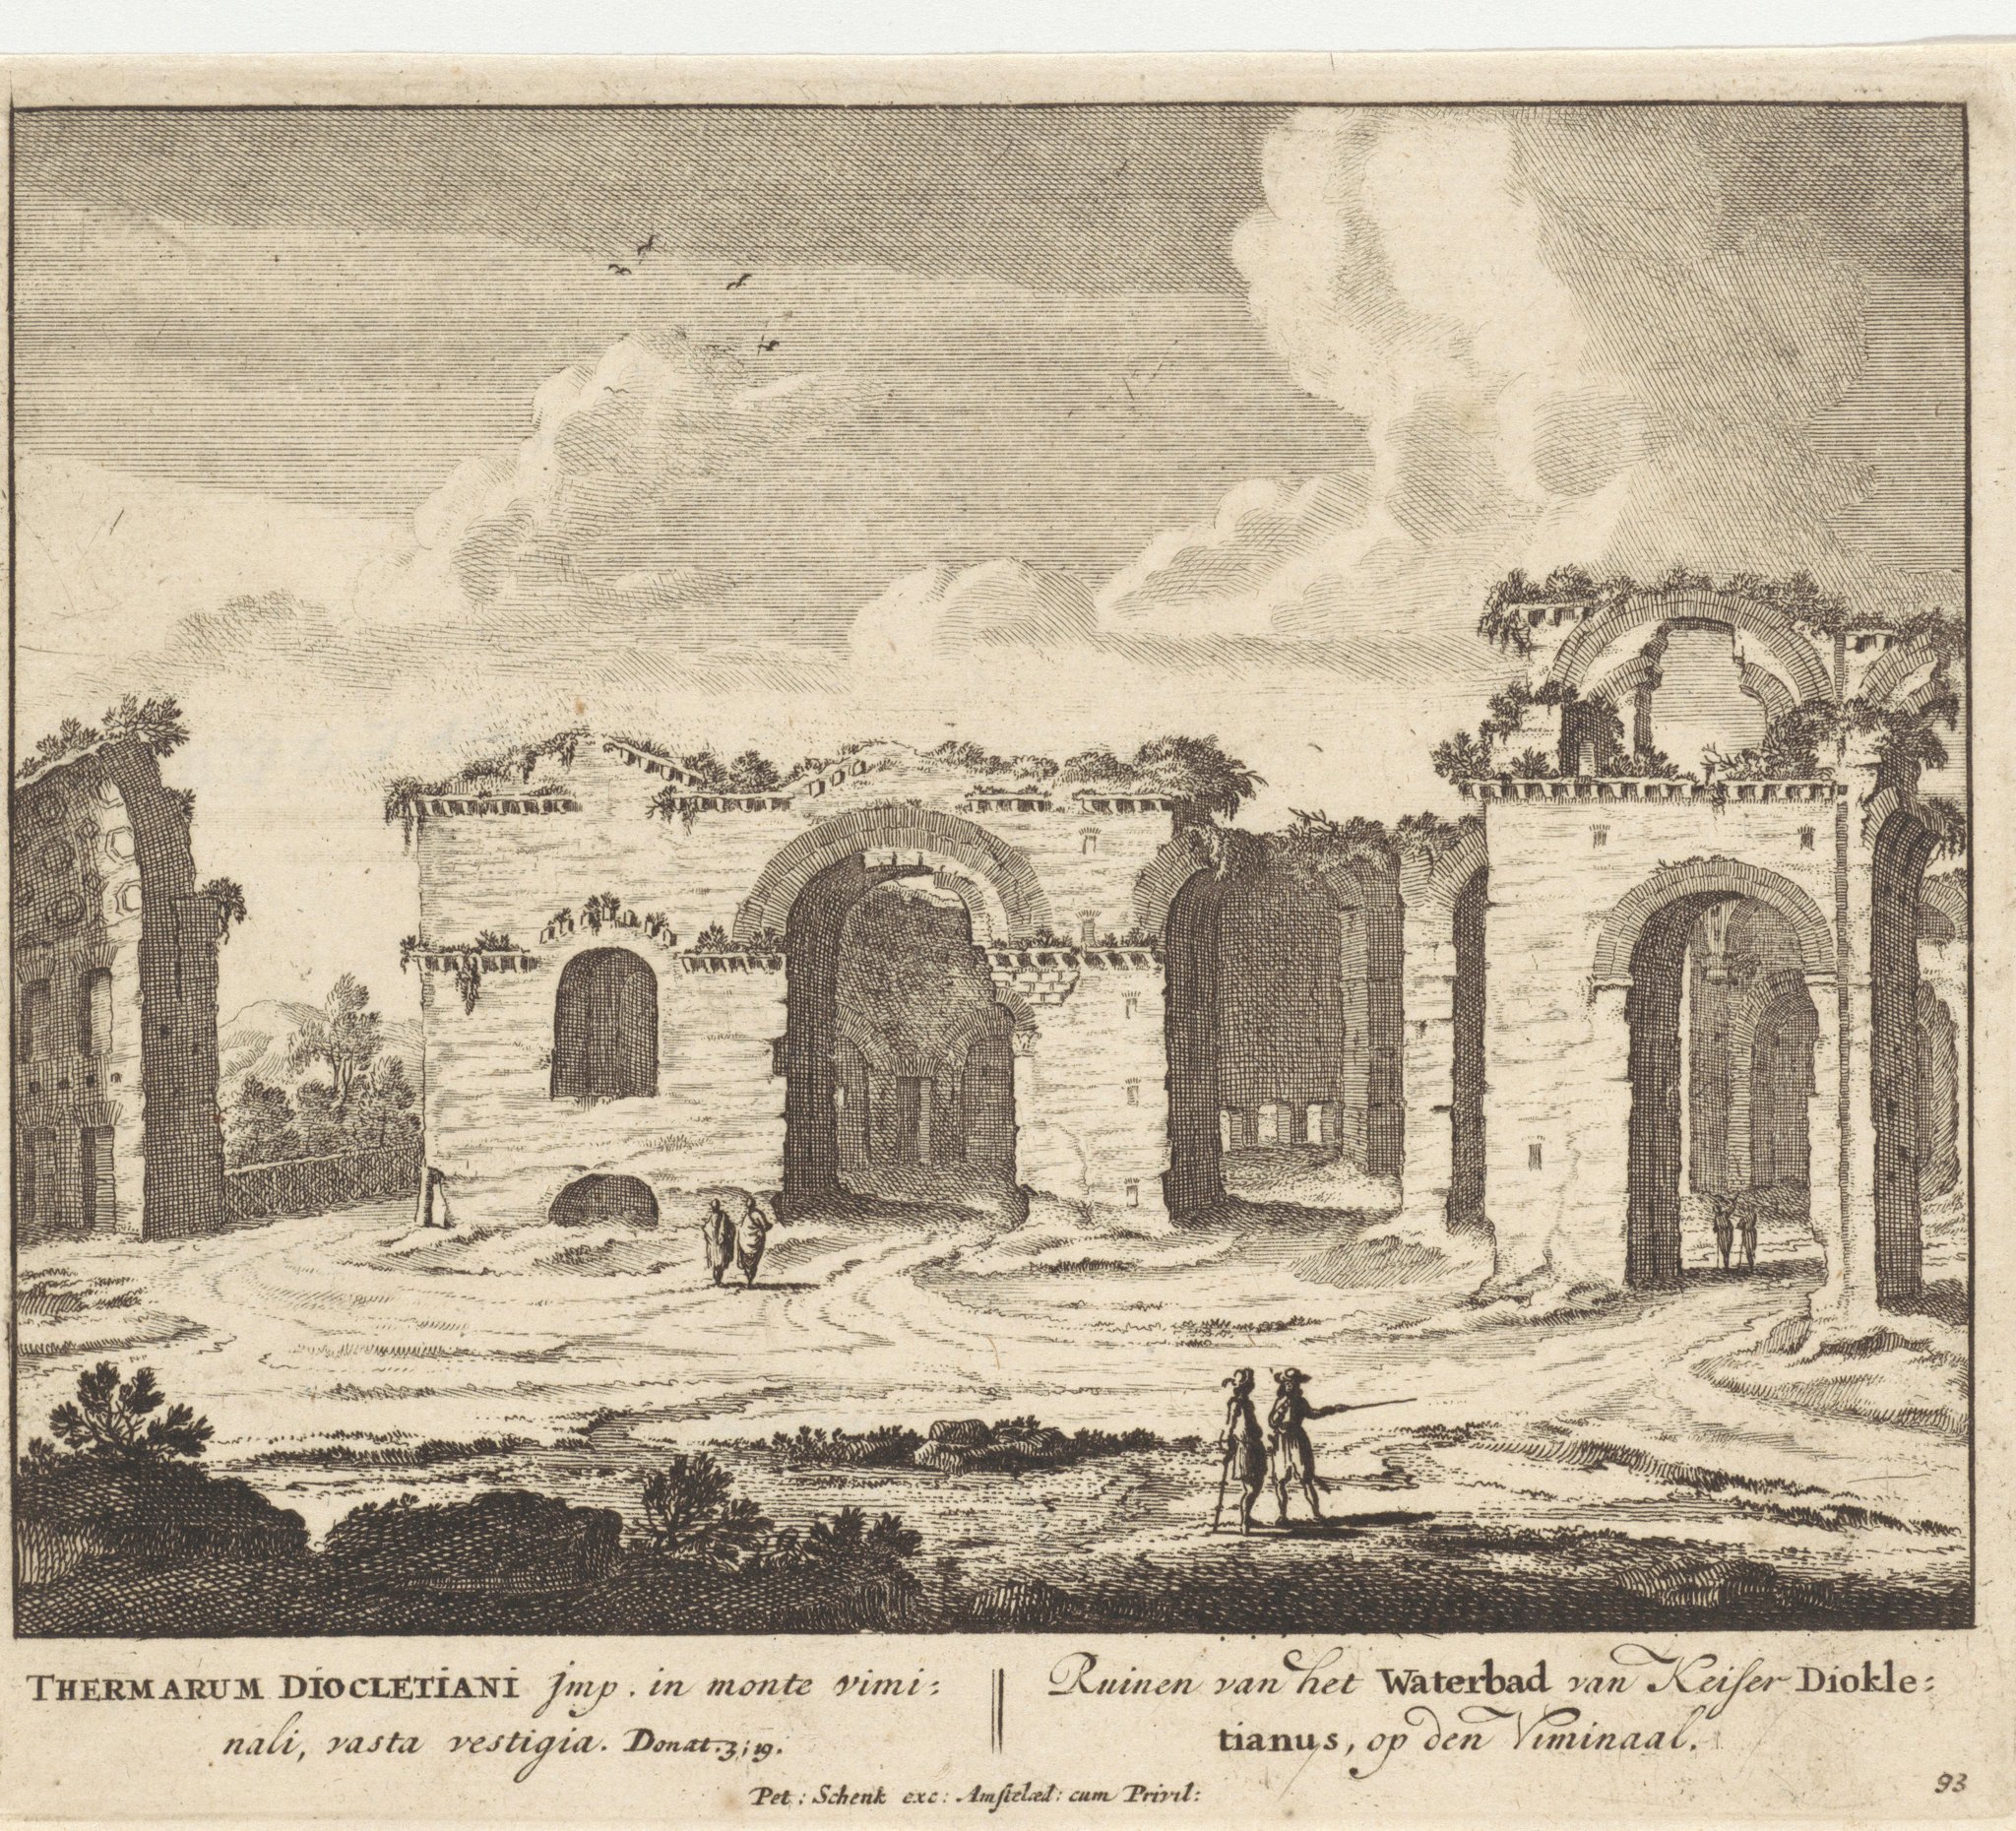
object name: print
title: Gezichten in Rome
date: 1675-1711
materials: paper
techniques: etching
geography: amsterdam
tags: ruin of a building ~ architecture, public baths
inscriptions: collector's mark: Lugt 2228